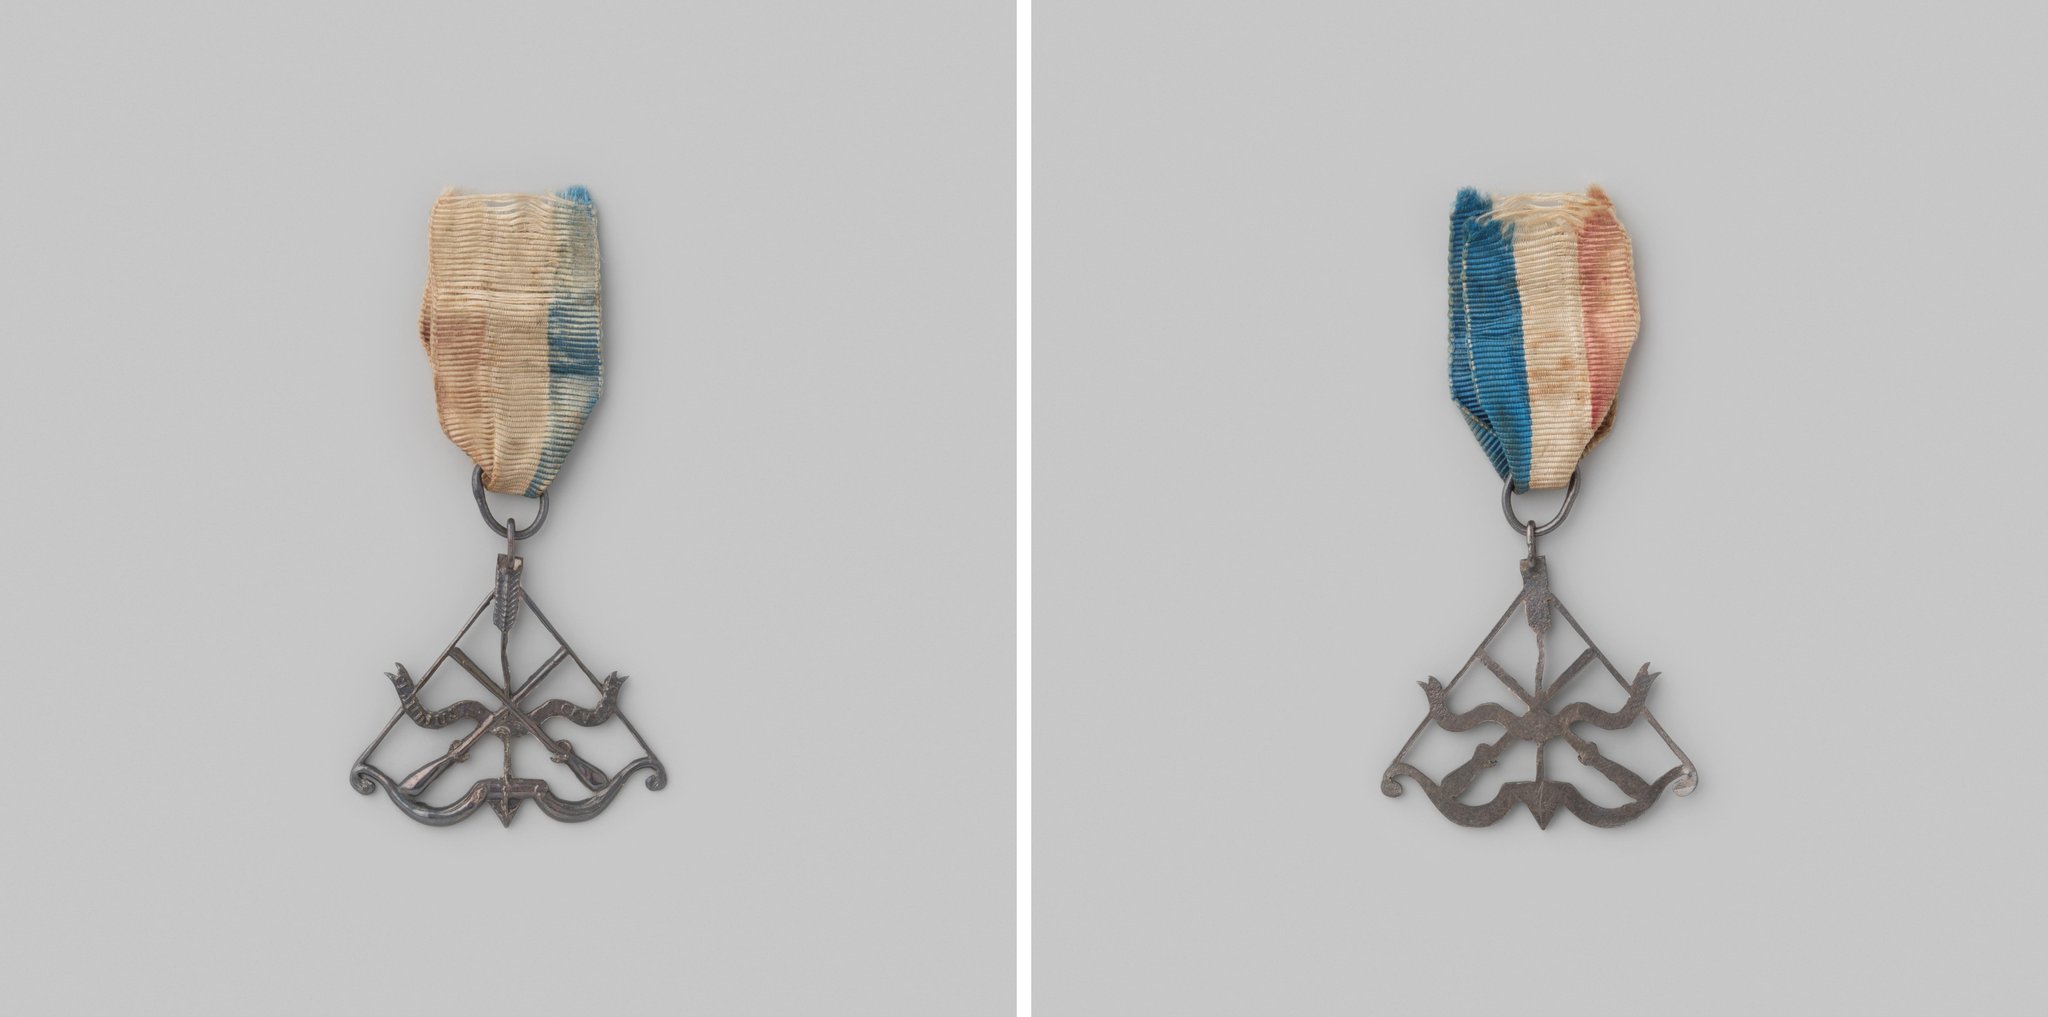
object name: insignia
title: Draagteken van de Koninklijke Handboogschutterij en Weerbaarheidsvereeniging Claudius Civilis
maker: Anonymous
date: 1851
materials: textile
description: Zilveren draagteken met oog, ring en lint.